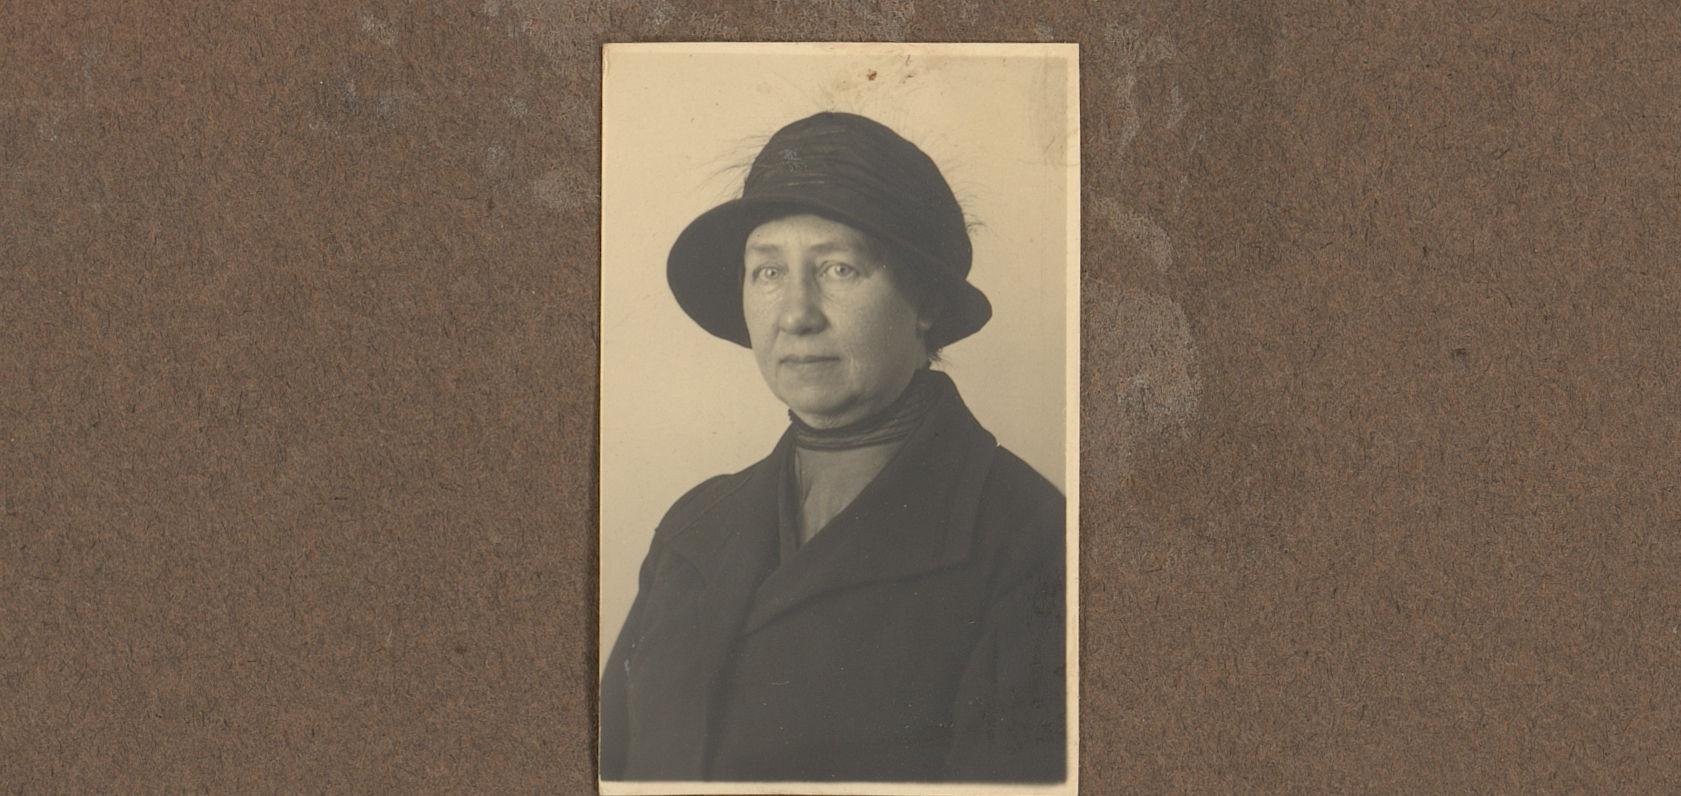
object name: photograph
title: Mevrouw Diepenbrock met dophoed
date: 1900-1915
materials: photographic support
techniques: photography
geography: netherlands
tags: jonkvrouw wilhelmina elisabeth petronella cornelia de jong van beek en donk, netherlands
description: Foto op bruin albumblad 53 van familiealbum van Alphons Diepenbrock.